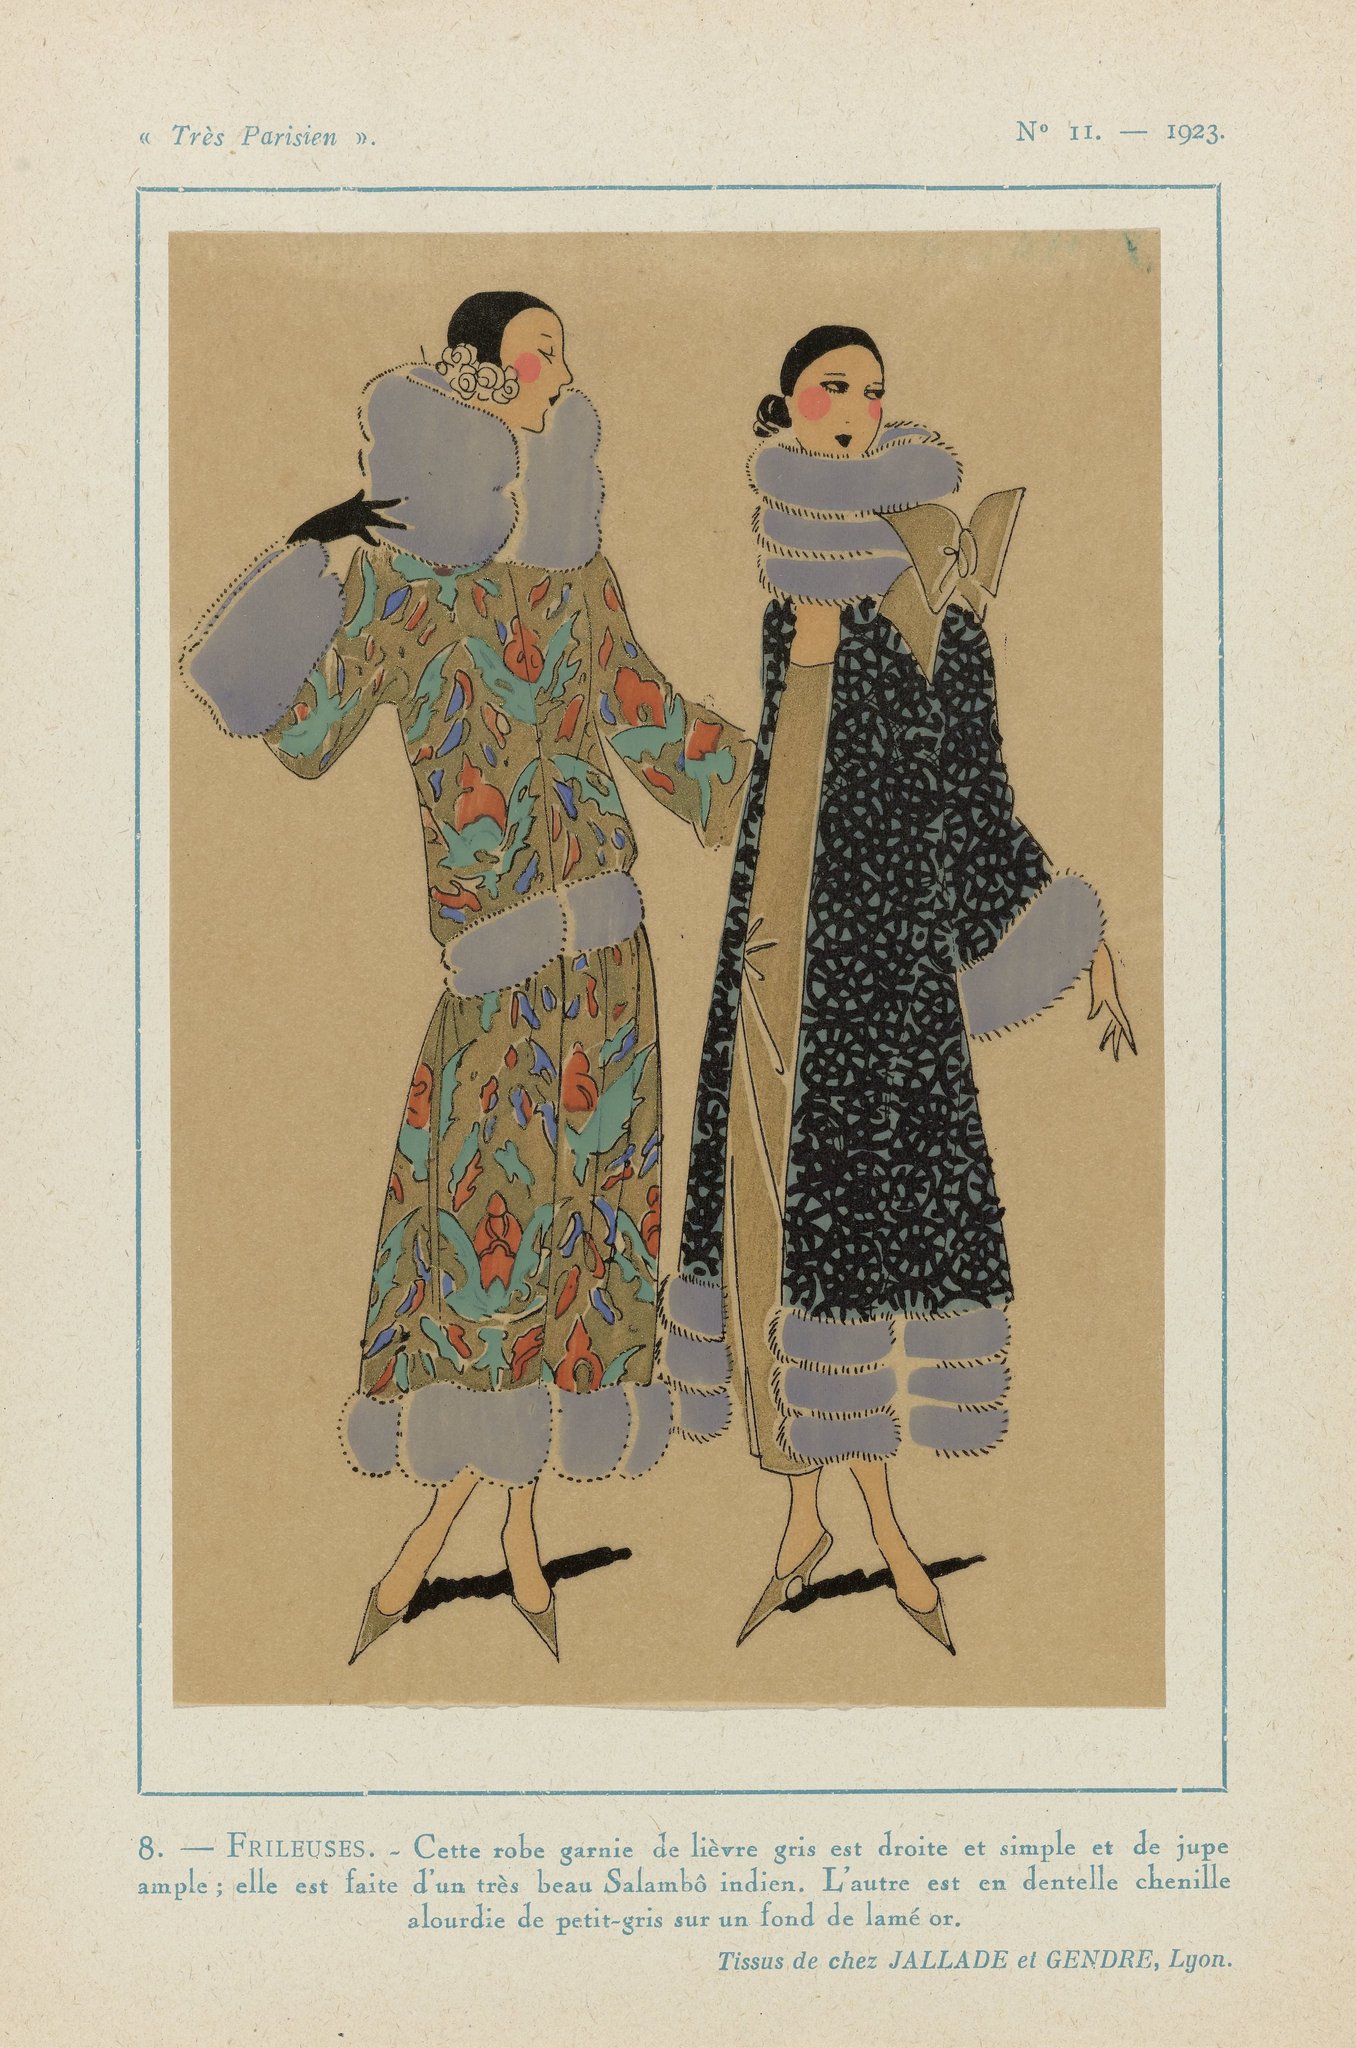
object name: fashion print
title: Très Parisien, 1923, No 11: 8. - FRILEUSES. - Cette robe garnie de lièvre gris...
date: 1923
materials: paper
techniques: hand coloring, letterpress printing, lithography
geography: lyon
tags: lace (+ women's clothes), border, ribbon, braid (+ fur used for clothes), dress, gown (+ lace used for clothes), fashion plates, dress, gown (+ women's clothes), neck-gear: collar (+ fur used for clothes)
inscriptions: title: ‘Très Parisien / No 11. - 1923’, caption: ‘8. - FRILEUSES. - Cette robe garnie de lièvre gris est droite et simple et de jupe ample; elle est faite d'un très beau Salambô indien. L'autre est en dentelle chenille alourdie de petit-gris sur un fond de lamé or. / Tissus de chez JALLADE et GENDRE, Lyon.’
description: Jurk van 'Salambô indien' gegarneerd met grijs hazenbont. De andere jurk is van 'dentelle chenille' (kant) versierd met 'petit gris' (bont) op een ondergrond van goudlamé. Stoffen van Jallade et Gendre. Prent uit het modetijdschrift Très Parisien (1920-1936).